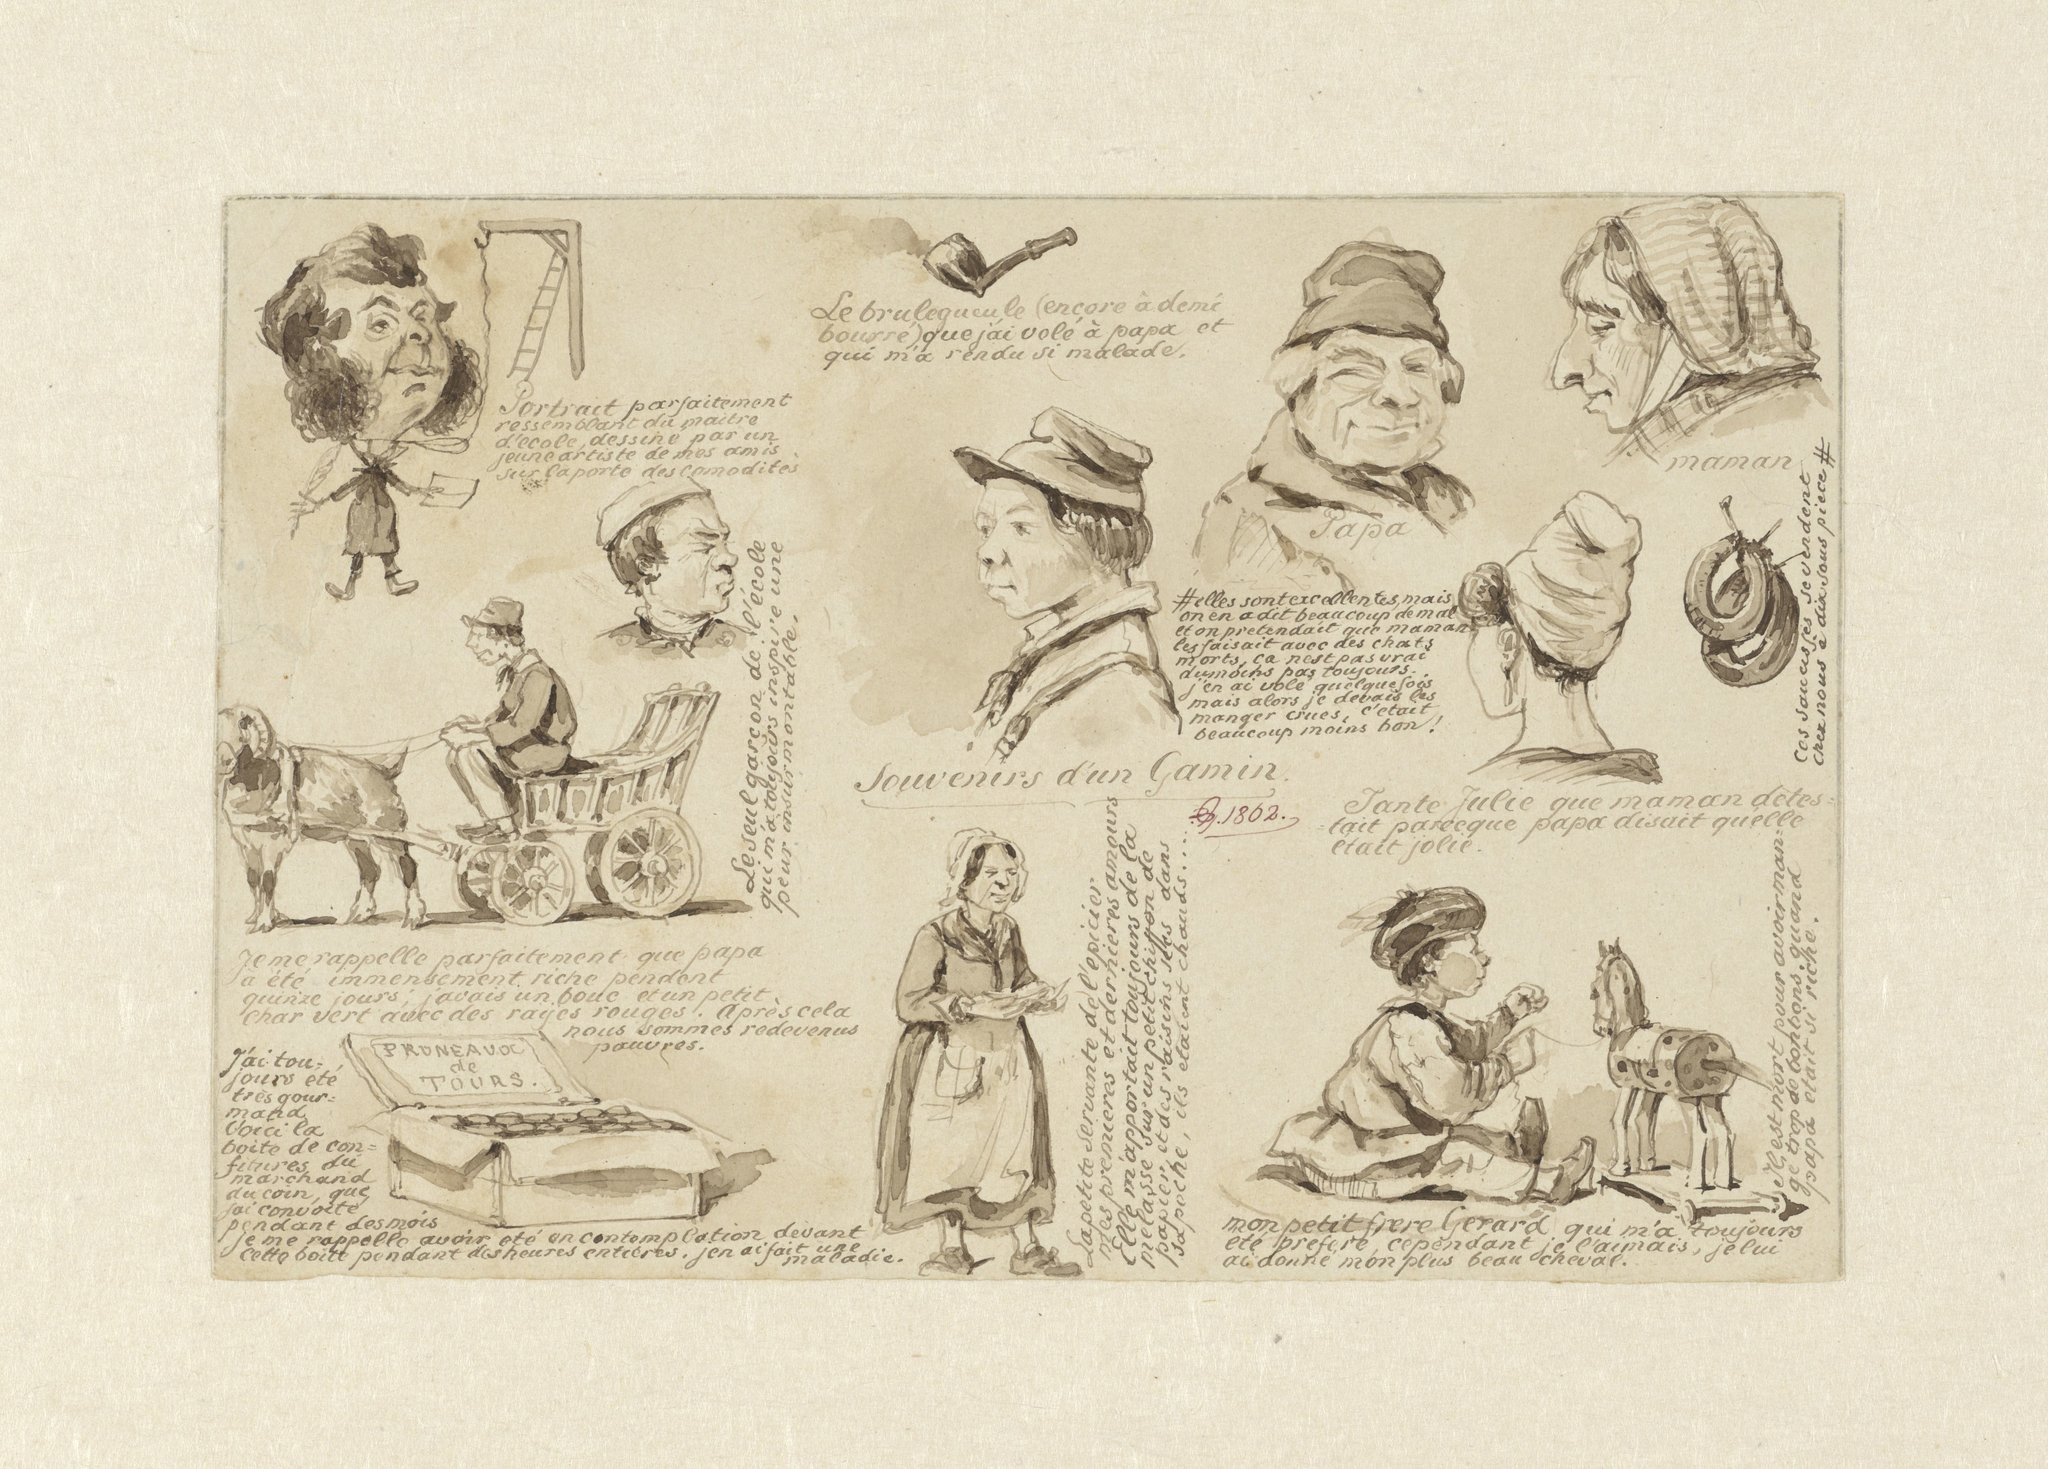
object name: drawing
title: Souvenirs d'un Gamin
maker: pieter van loon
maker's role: draughtsman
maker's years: 1801-1873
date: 1862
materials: ink, paper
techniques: brush, pen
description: Karikaturen met uitgebreide bijschriften.